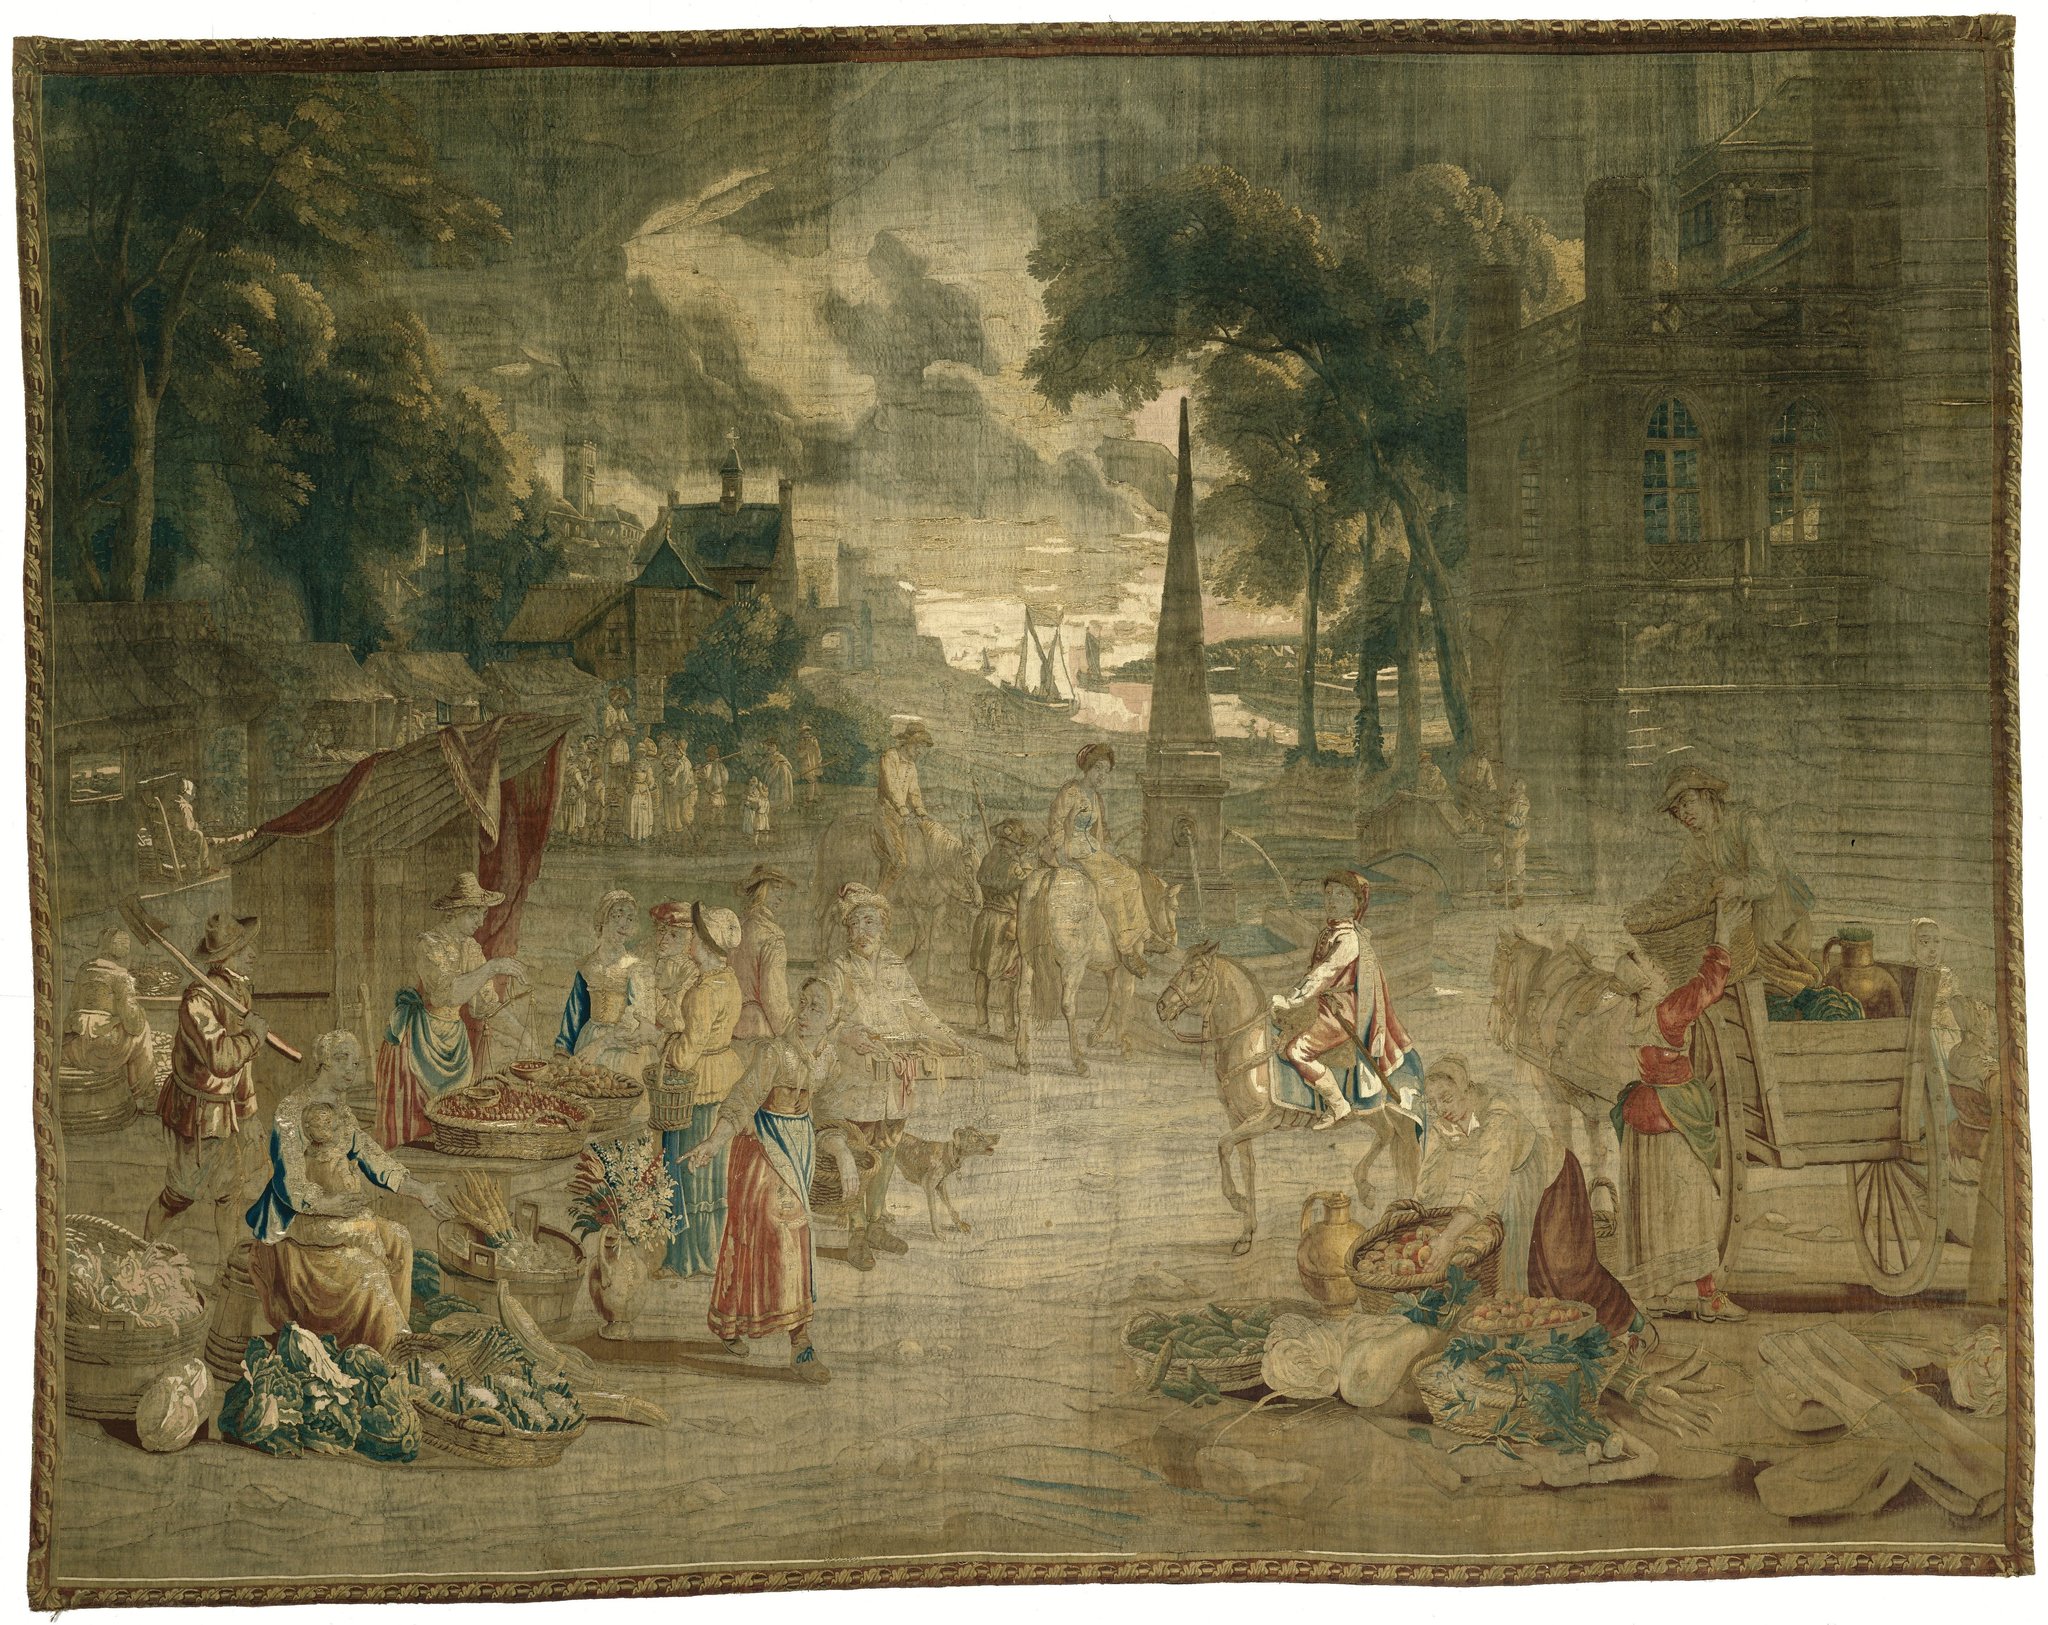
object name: tapestry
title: De fruit- en groentemarkt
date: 1729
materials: silk, wool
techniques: tapestry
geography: brussels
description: Wandtapijt met een een groente- en fruitmarkt met verschillende klanten. In de achtergrond een fontein, de stad en een haven. Het tapijt heeft een smalle rand met om een staaf gekrulde acanthusranken.